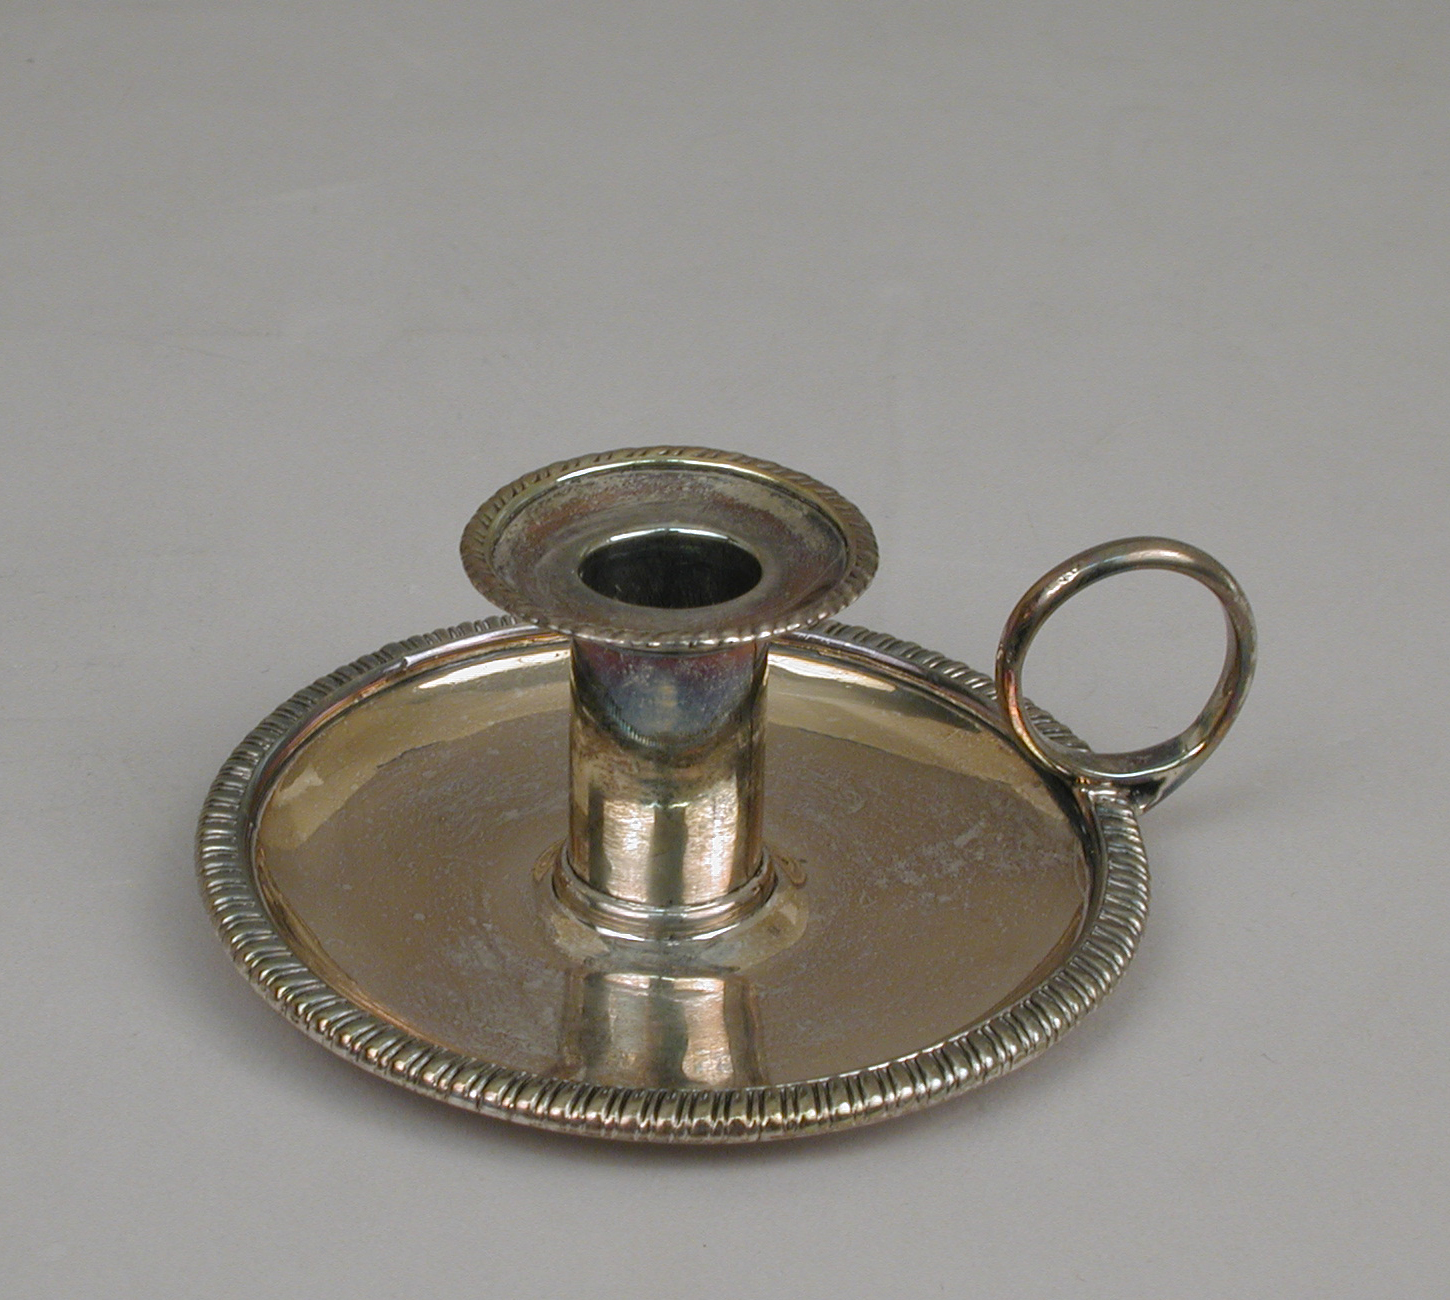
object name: chamber candlestick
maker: william fountain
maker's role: maker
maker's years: 1791-1821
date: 1808-1809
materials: silver